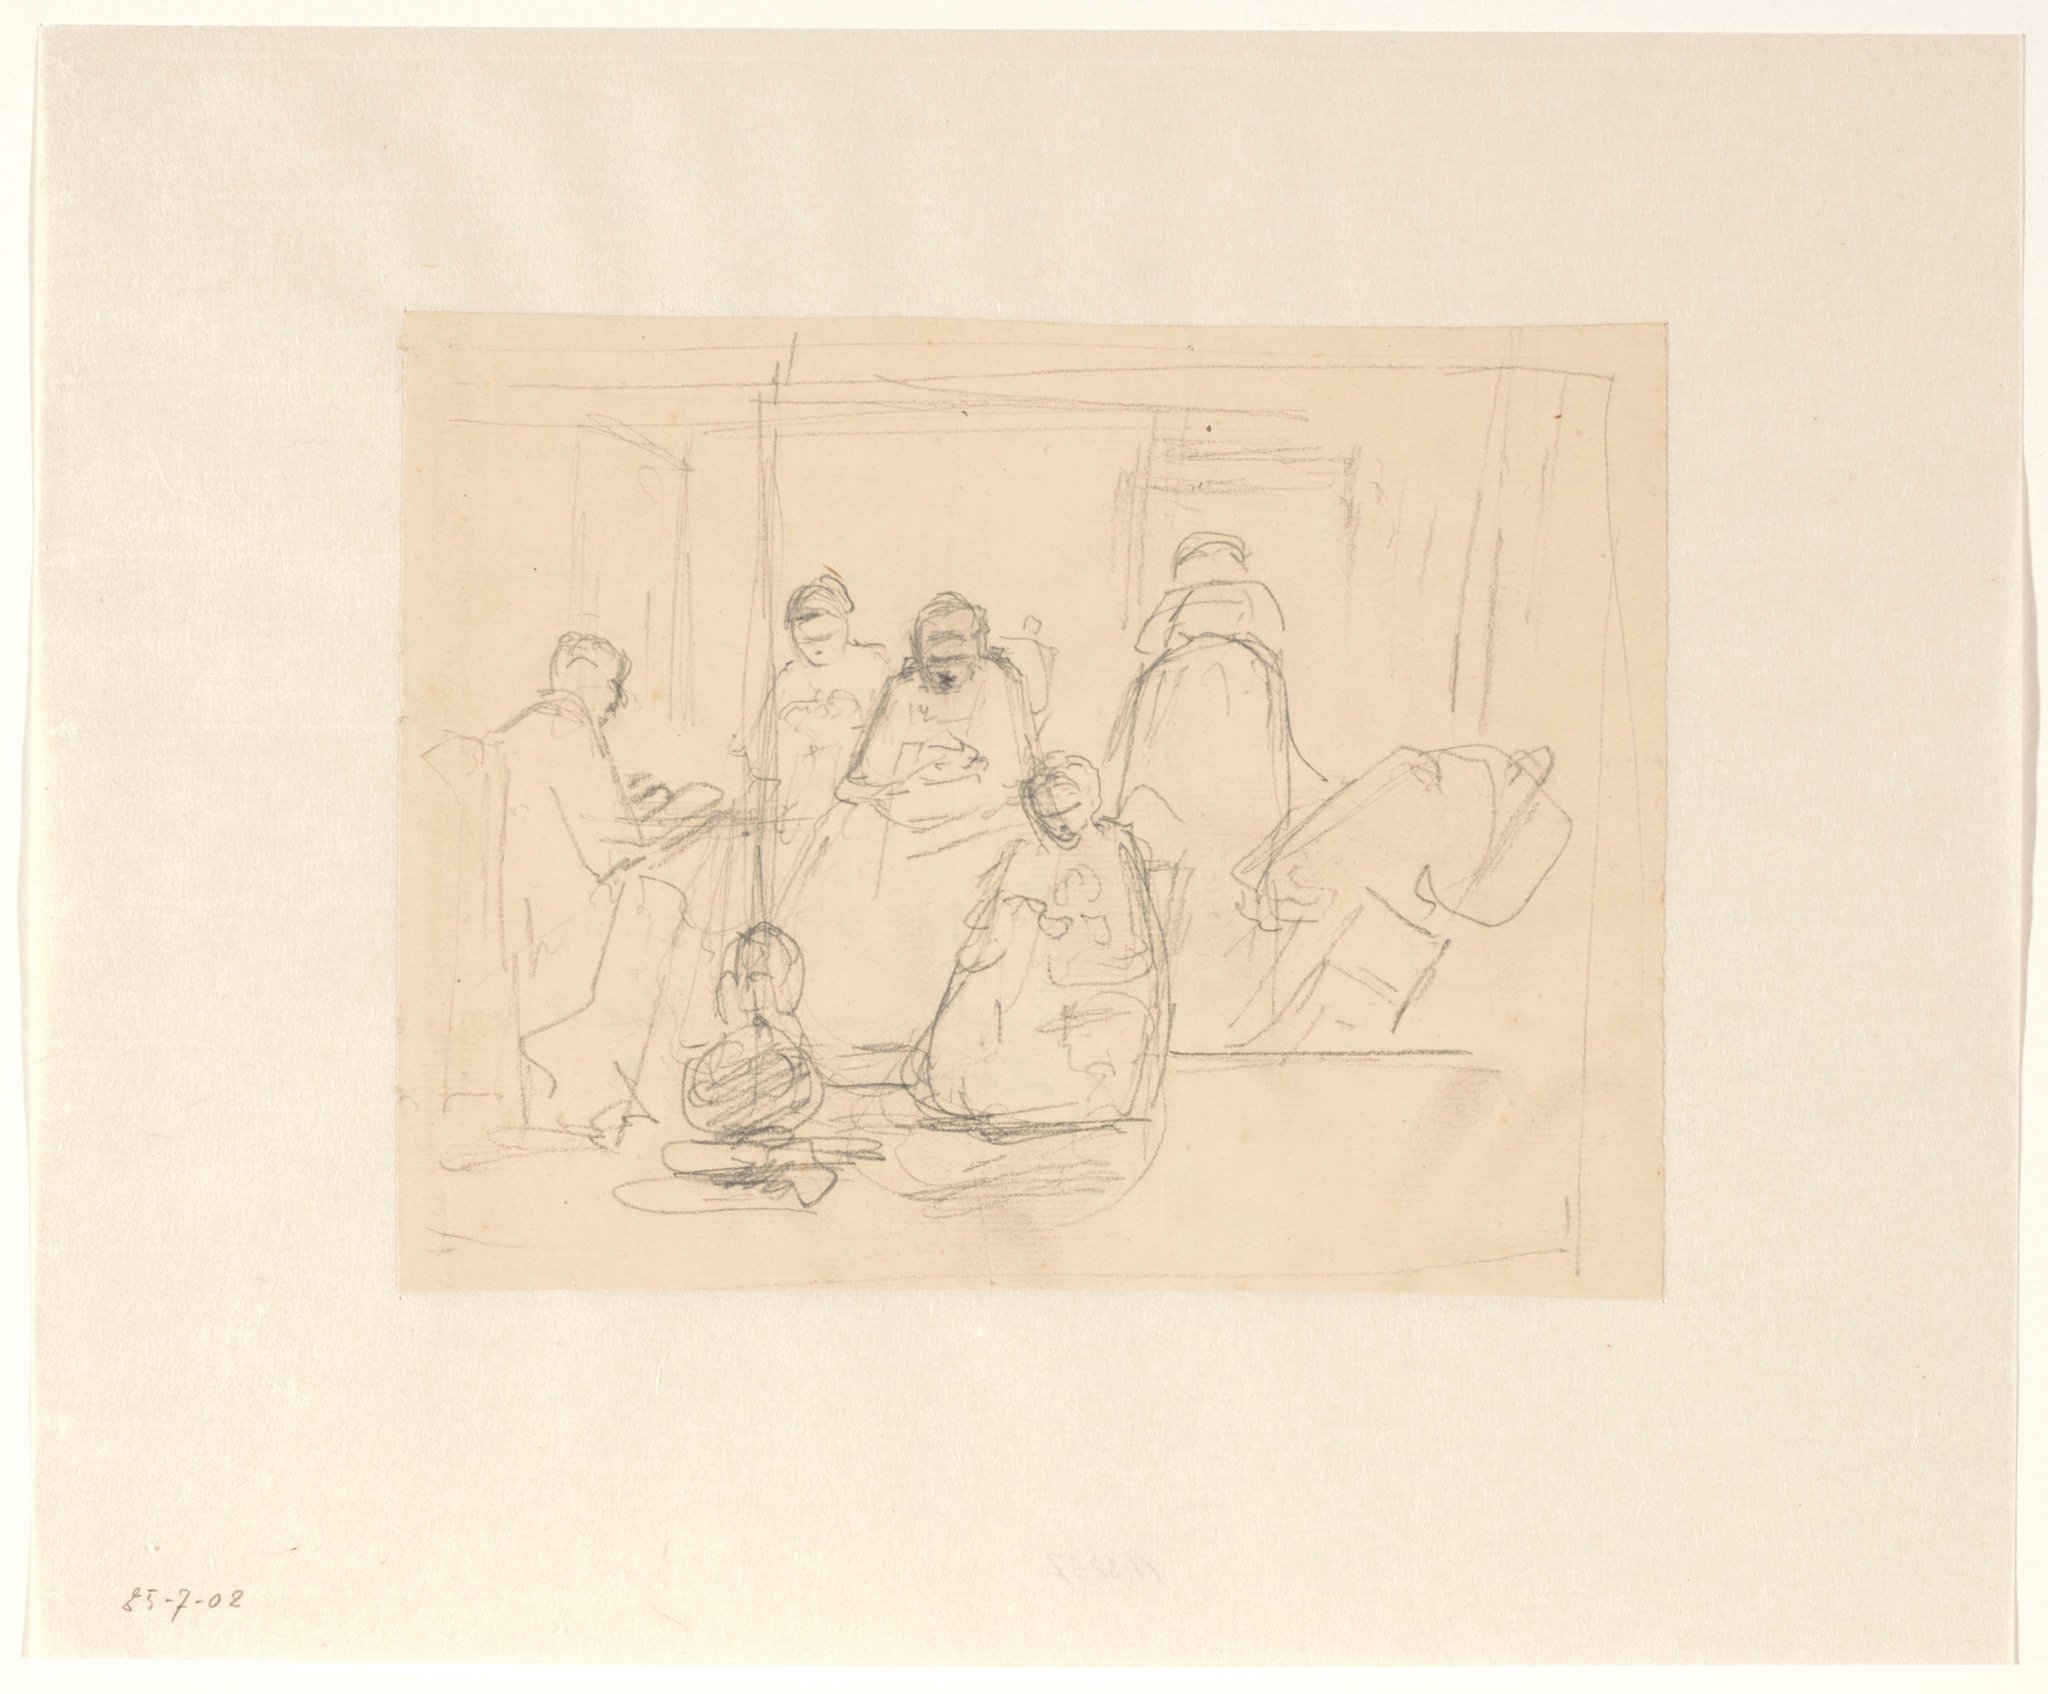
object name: drawing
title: Interieur met familie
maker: hendrik valkenburg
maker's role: draughtsman, painter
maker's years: 1826-1896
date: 1836-1896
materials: paper, pencil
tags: corridor, family group, especially parents with their child(ren), interior of the house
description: Vier zittende figuren en een staande. Verso: notities over een schilderijenzending.